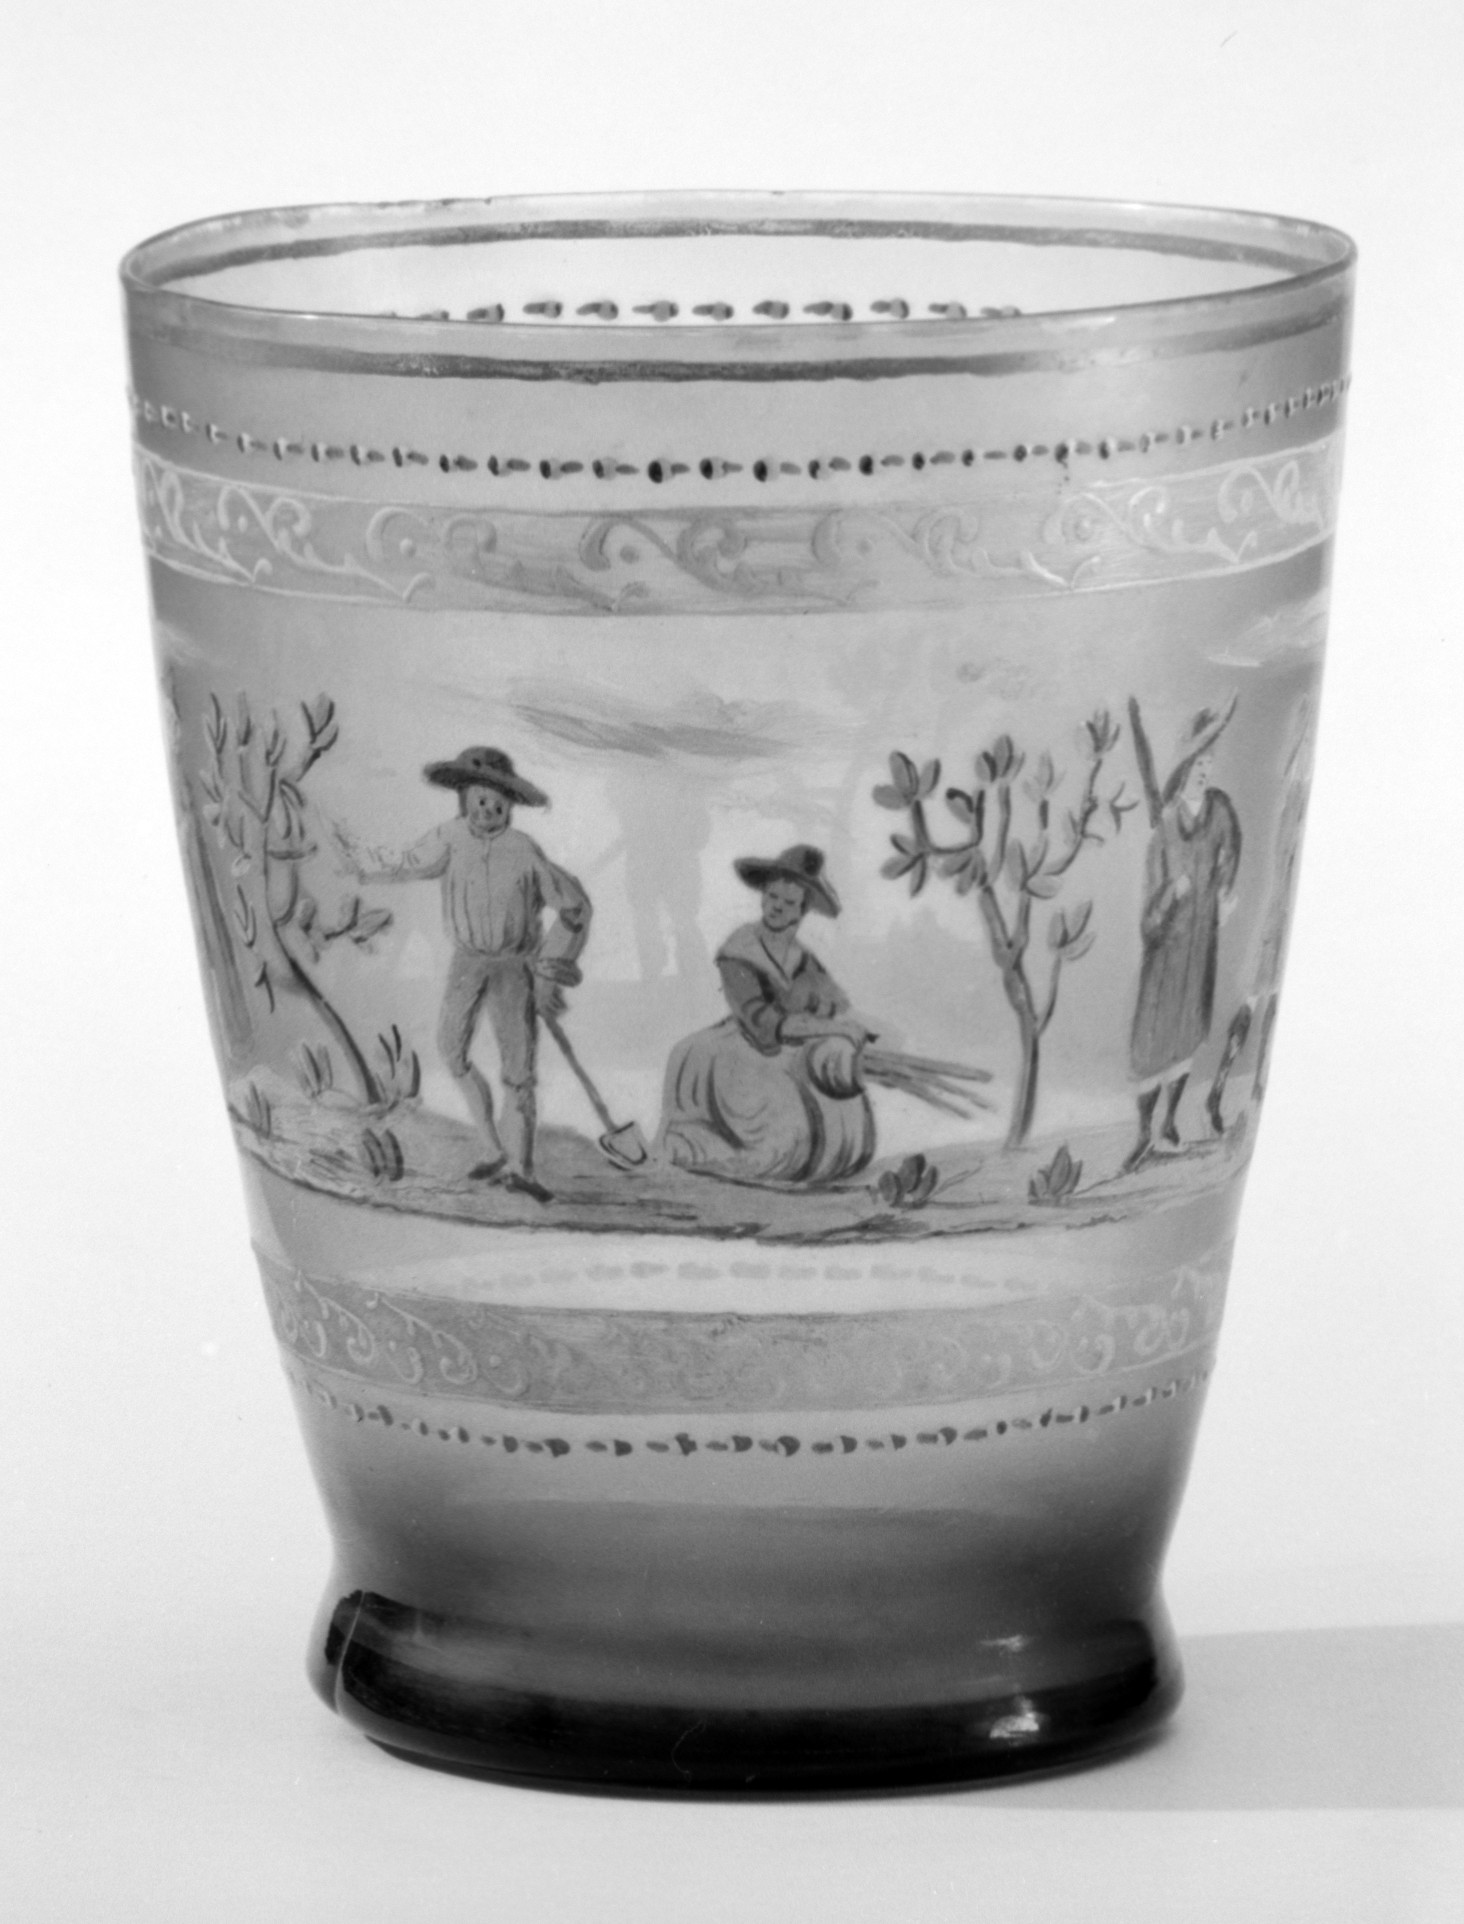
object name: beaker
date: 1801-1850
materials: glass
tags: men,women